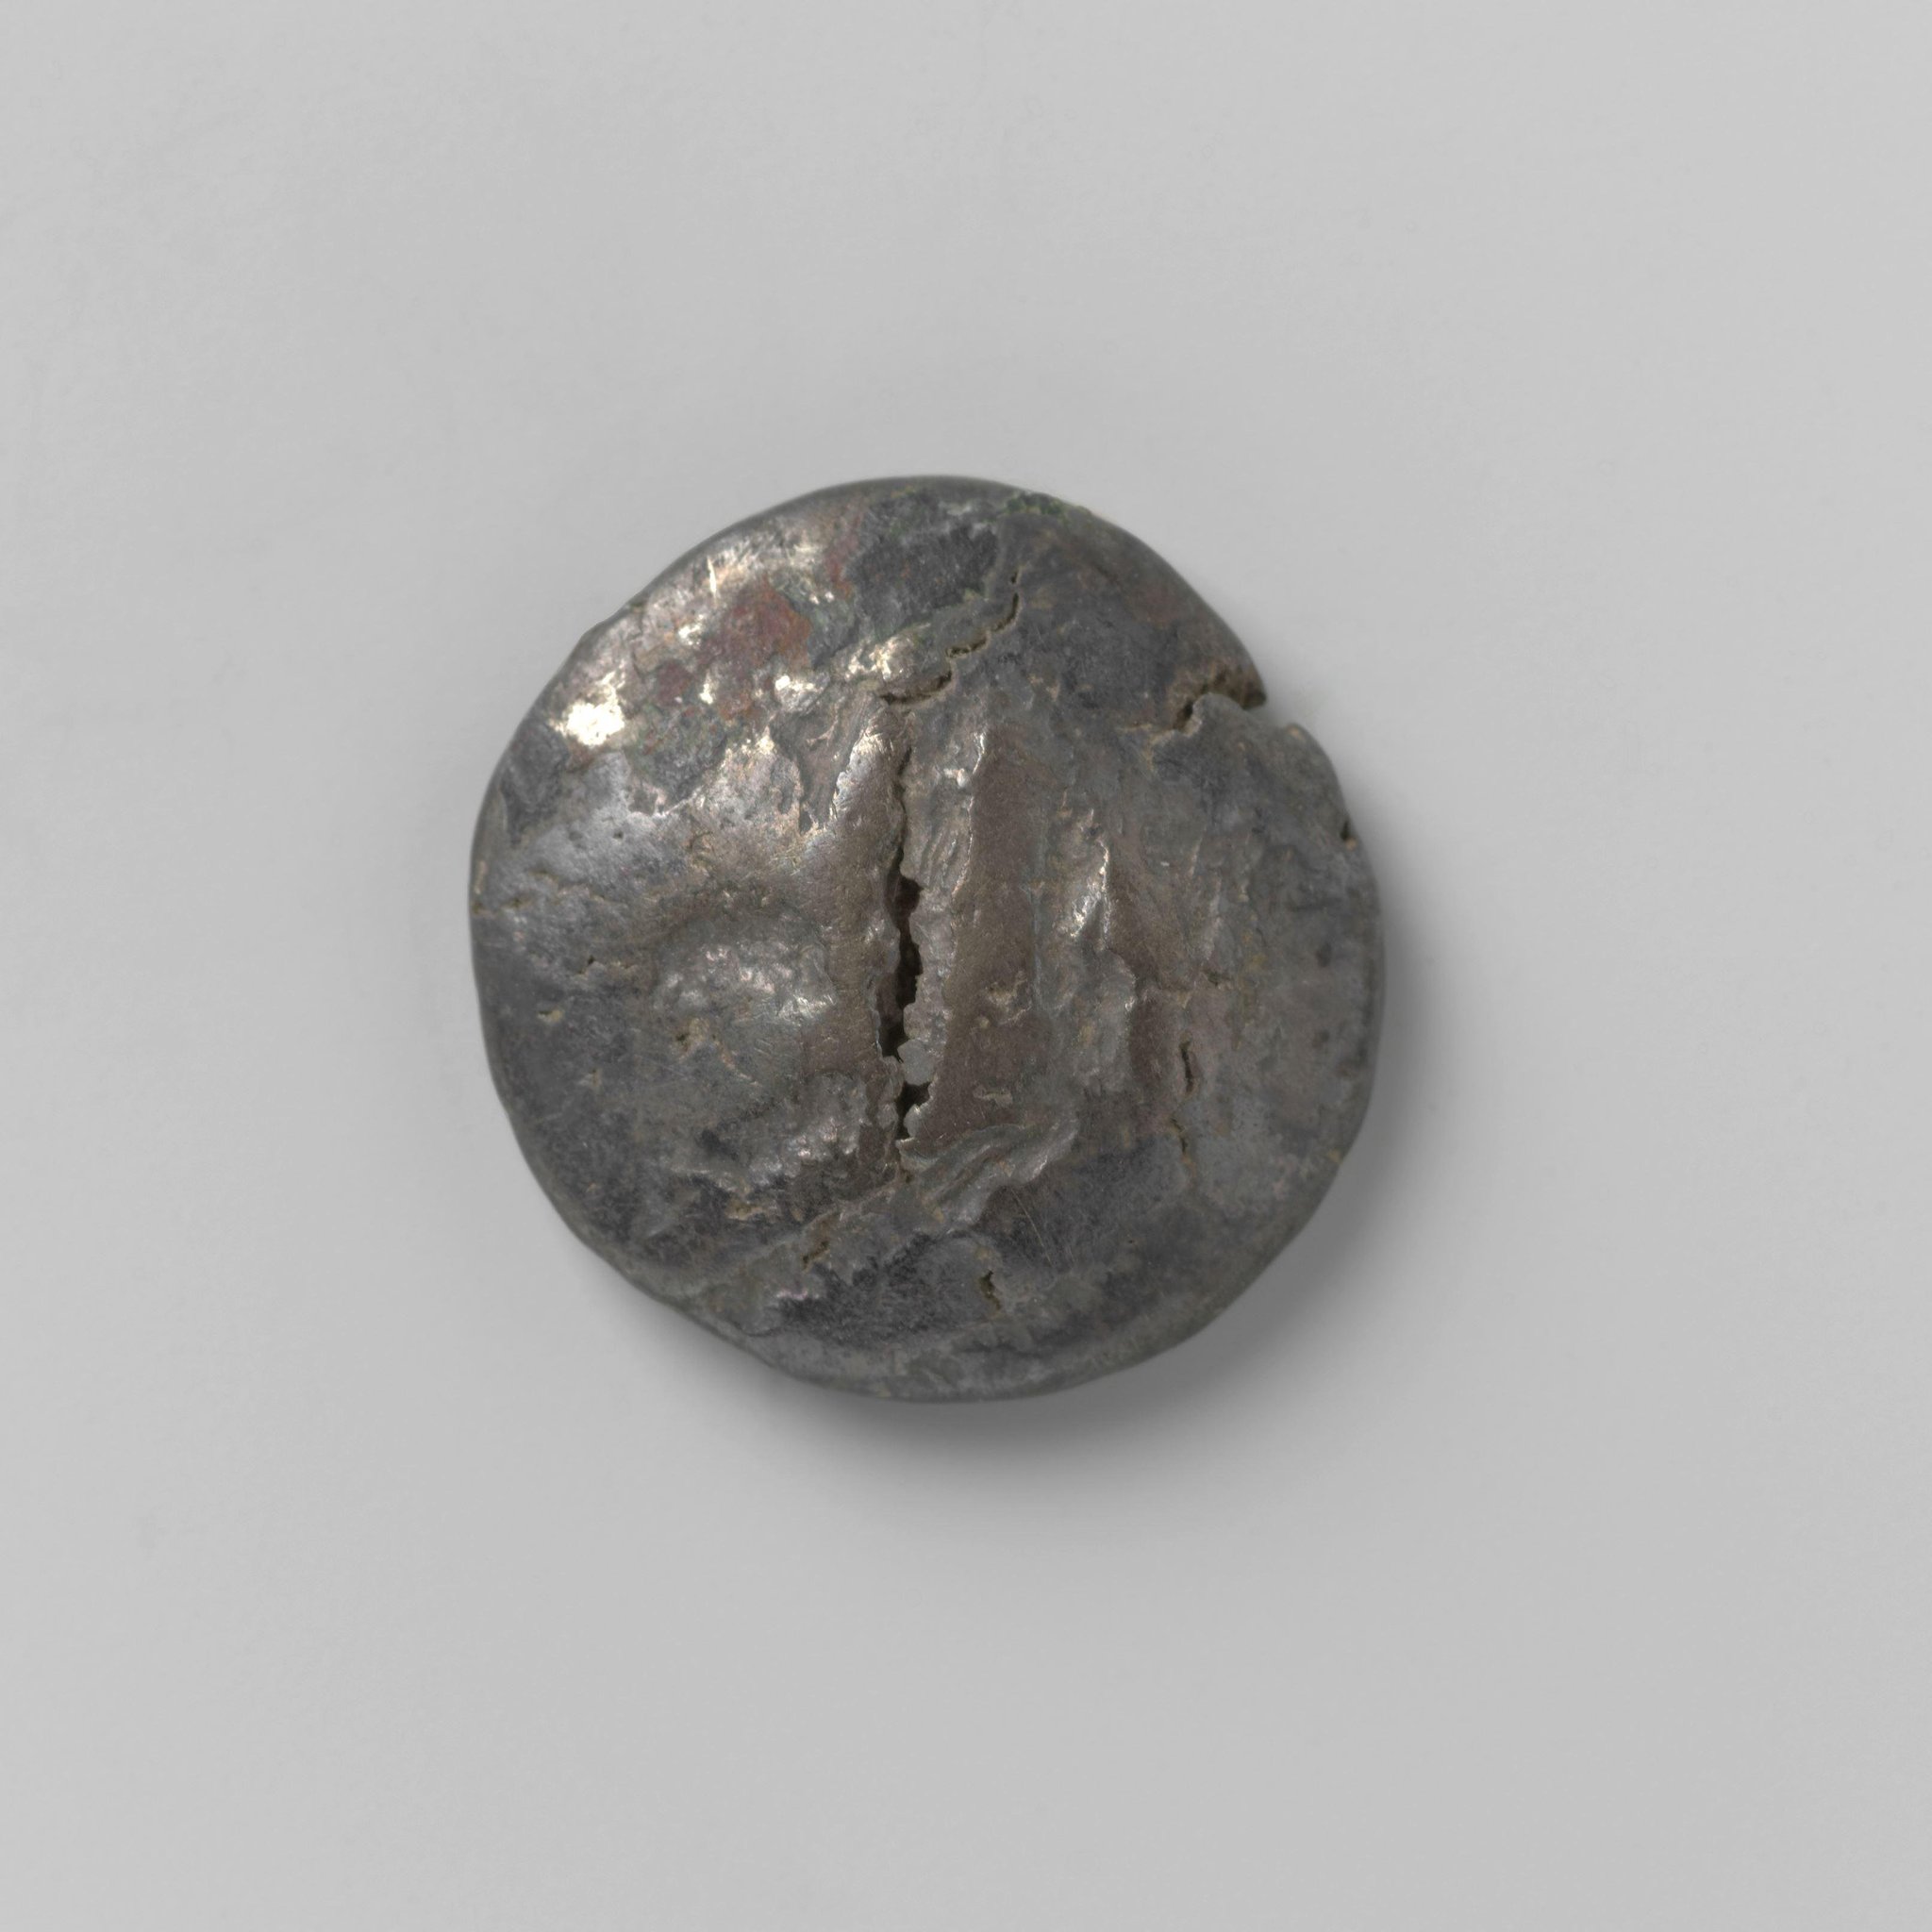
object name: coin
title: Djampel van koninkrijk Majopahit op Java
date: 1290-1520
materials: silver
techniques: striking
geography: java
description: Zilveren schotelvormige munt. Voorzijde: letterteken in devanagari-schrift [maa?]. Keerzijde, figuratie [bloem?].